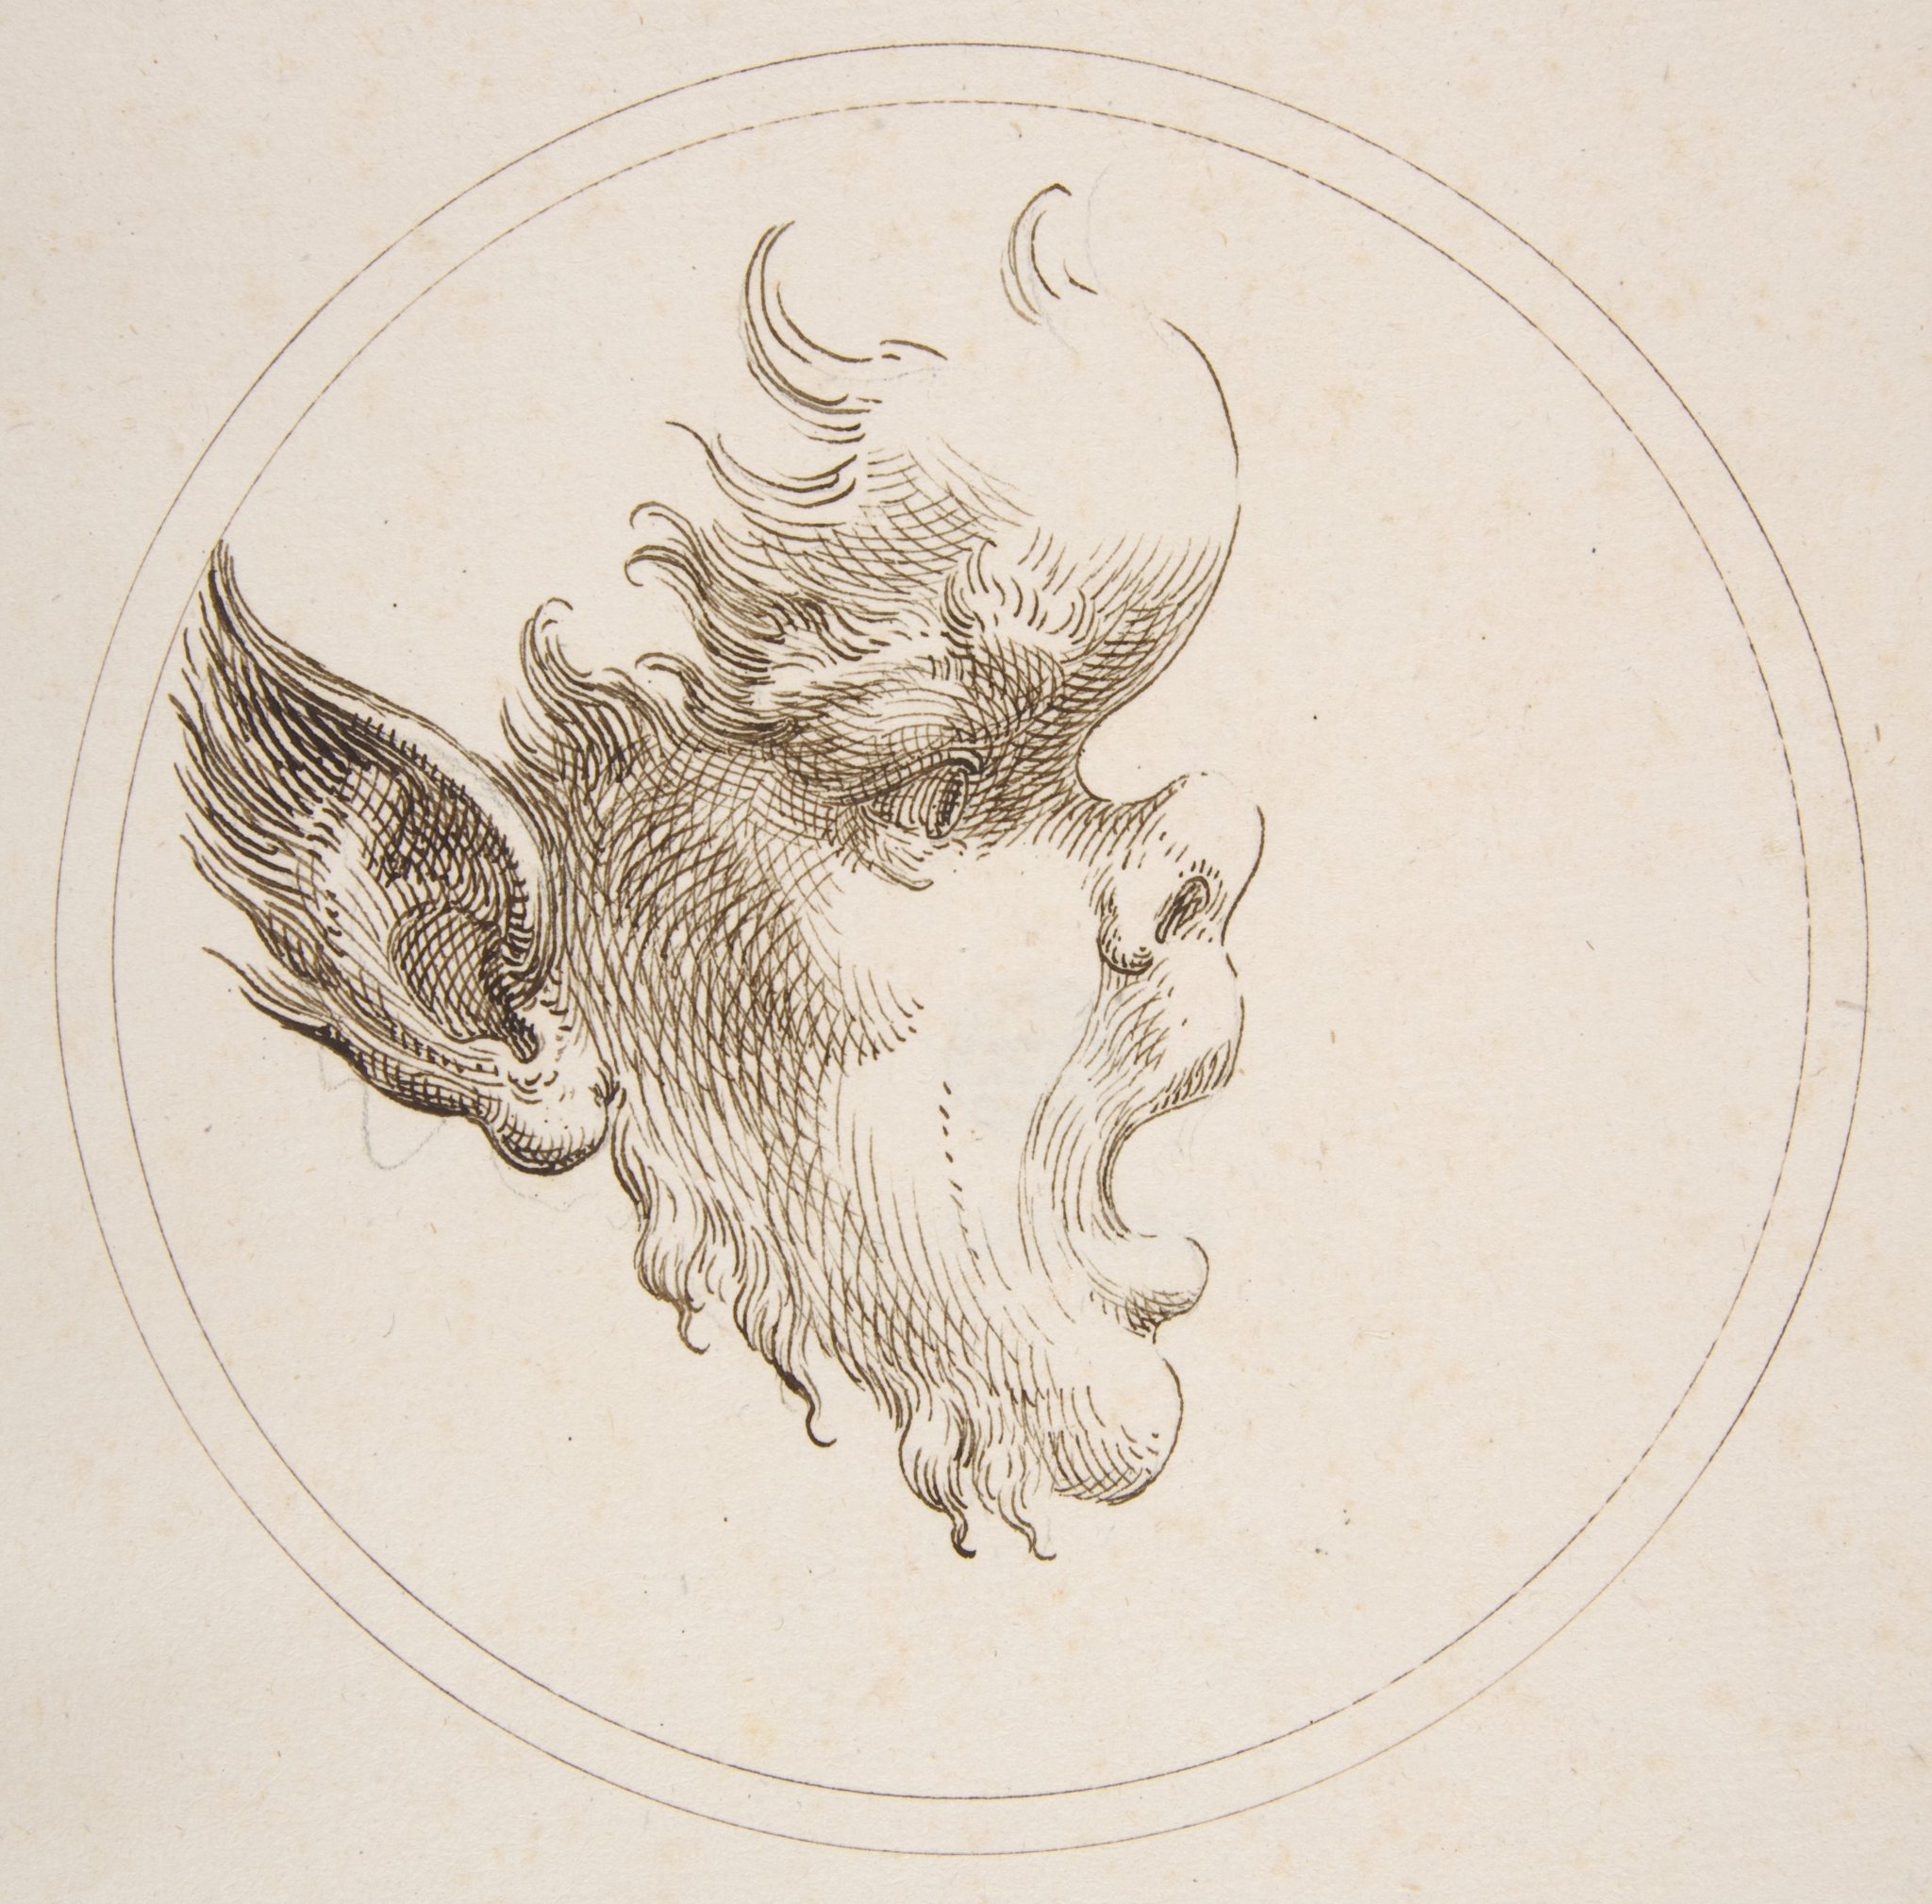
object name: drawing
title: Grotesque Head With a Bulging Forehead Looking to the Right Within a Circle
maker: gaetano piccini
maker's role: artist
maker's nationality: italian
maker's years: 1710-1730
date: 1727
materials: ink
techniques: pen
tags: heads